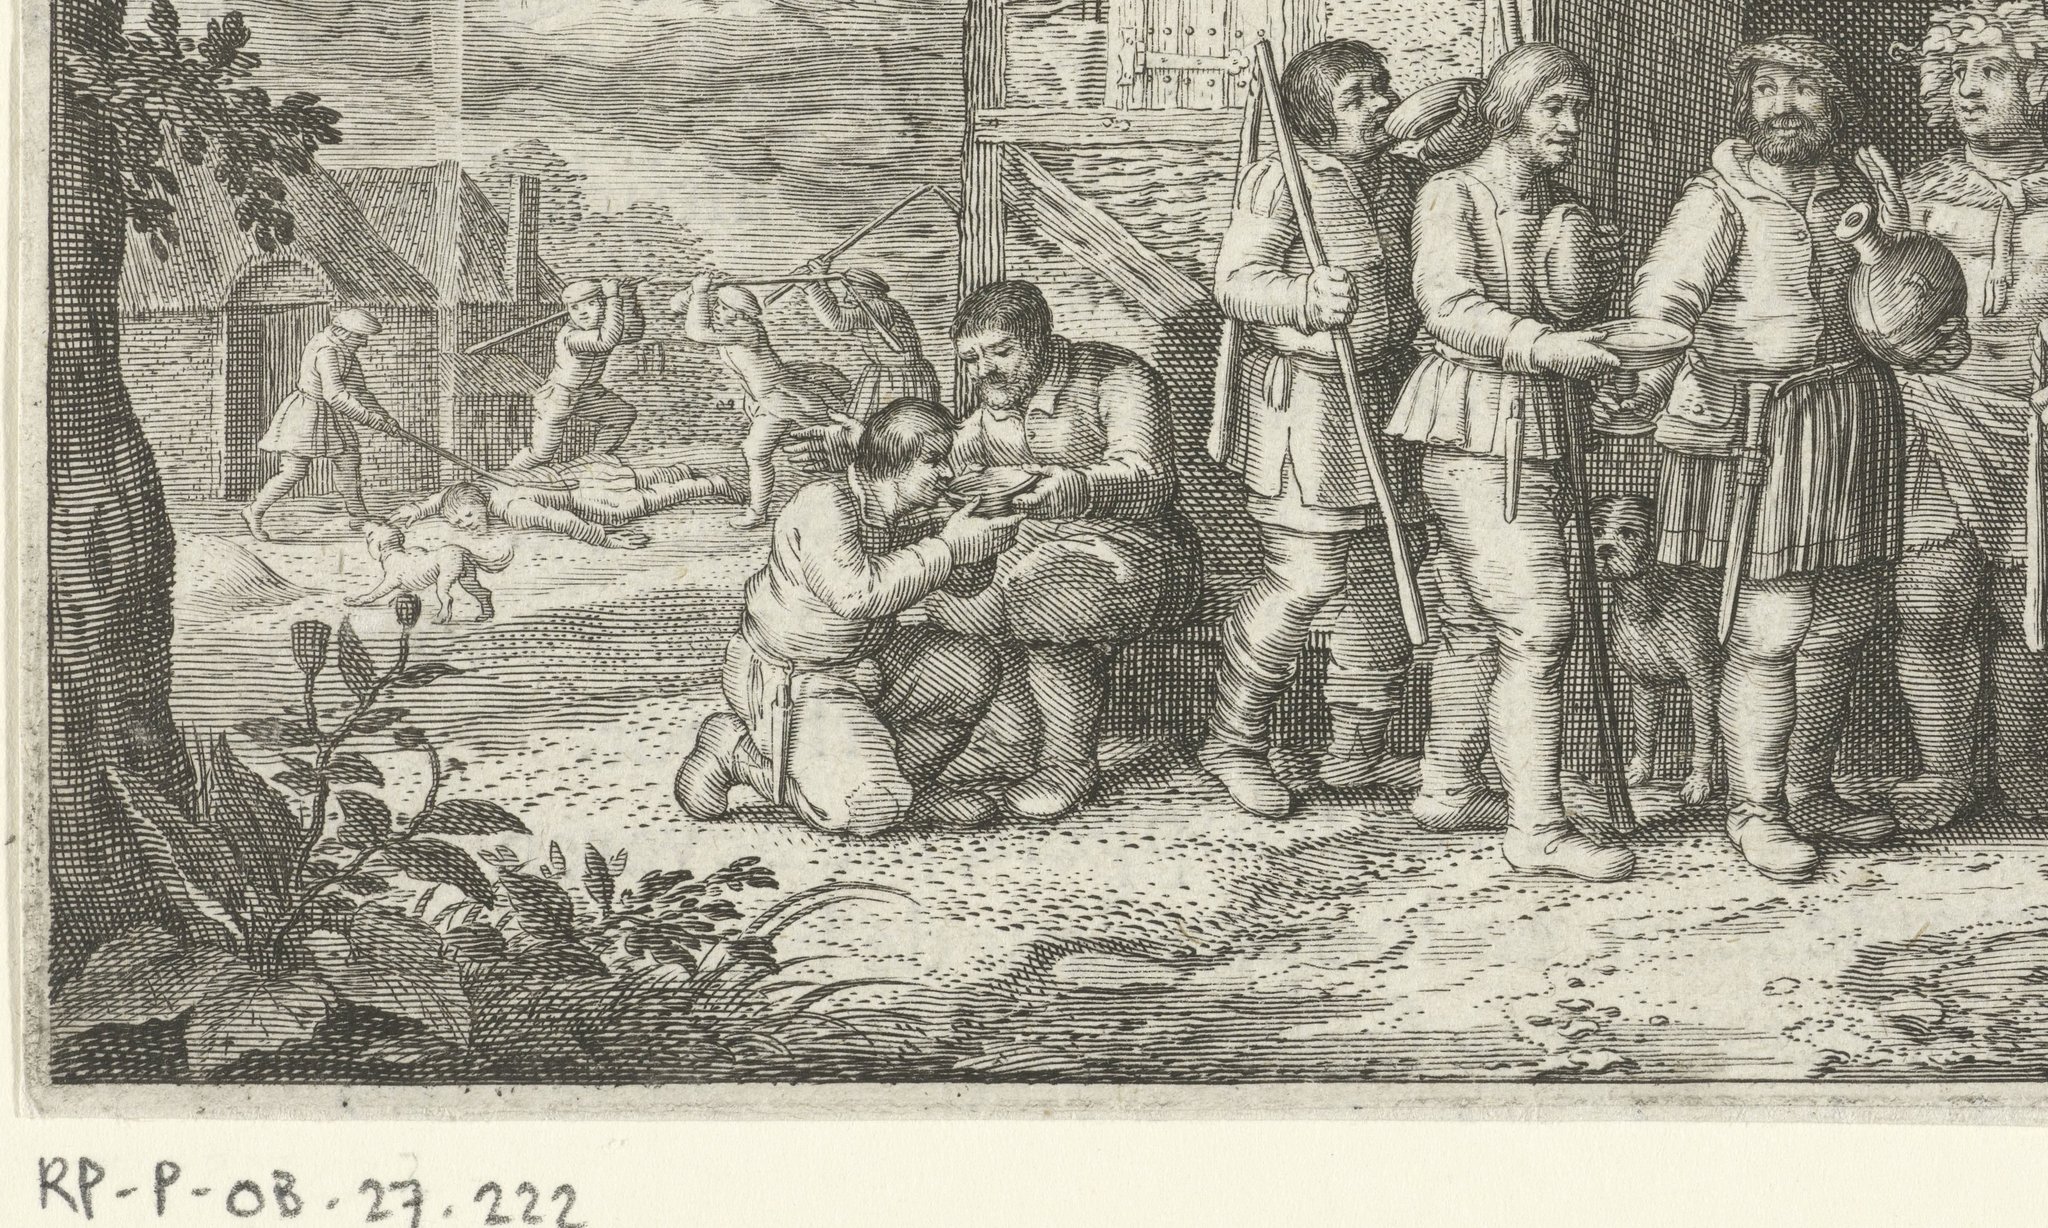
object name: book illustration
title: Bacchus met wijn bij boeren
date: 1616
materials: paper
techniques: engraving, letterpress printing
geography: amsterdam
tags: icarius changed into a constellation: after having been slain by angry farmers, icarius is changed into a constellation (ovid, metamorphoses x 450), (story of) bacchus (dionysus), liber, farmers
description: Boekillustratie voor: Heinsius, Daniel [bewerkt door Petrus Scriverius]. Nederduytsche poemata. dl. 3: Hymnus oft Lof-sanck van Bacchus, Waerin'tgebruyck ende misbruyck vande Wijn beschreven wort. Amsterdam: Willem Jansz Blaeu, 1616.